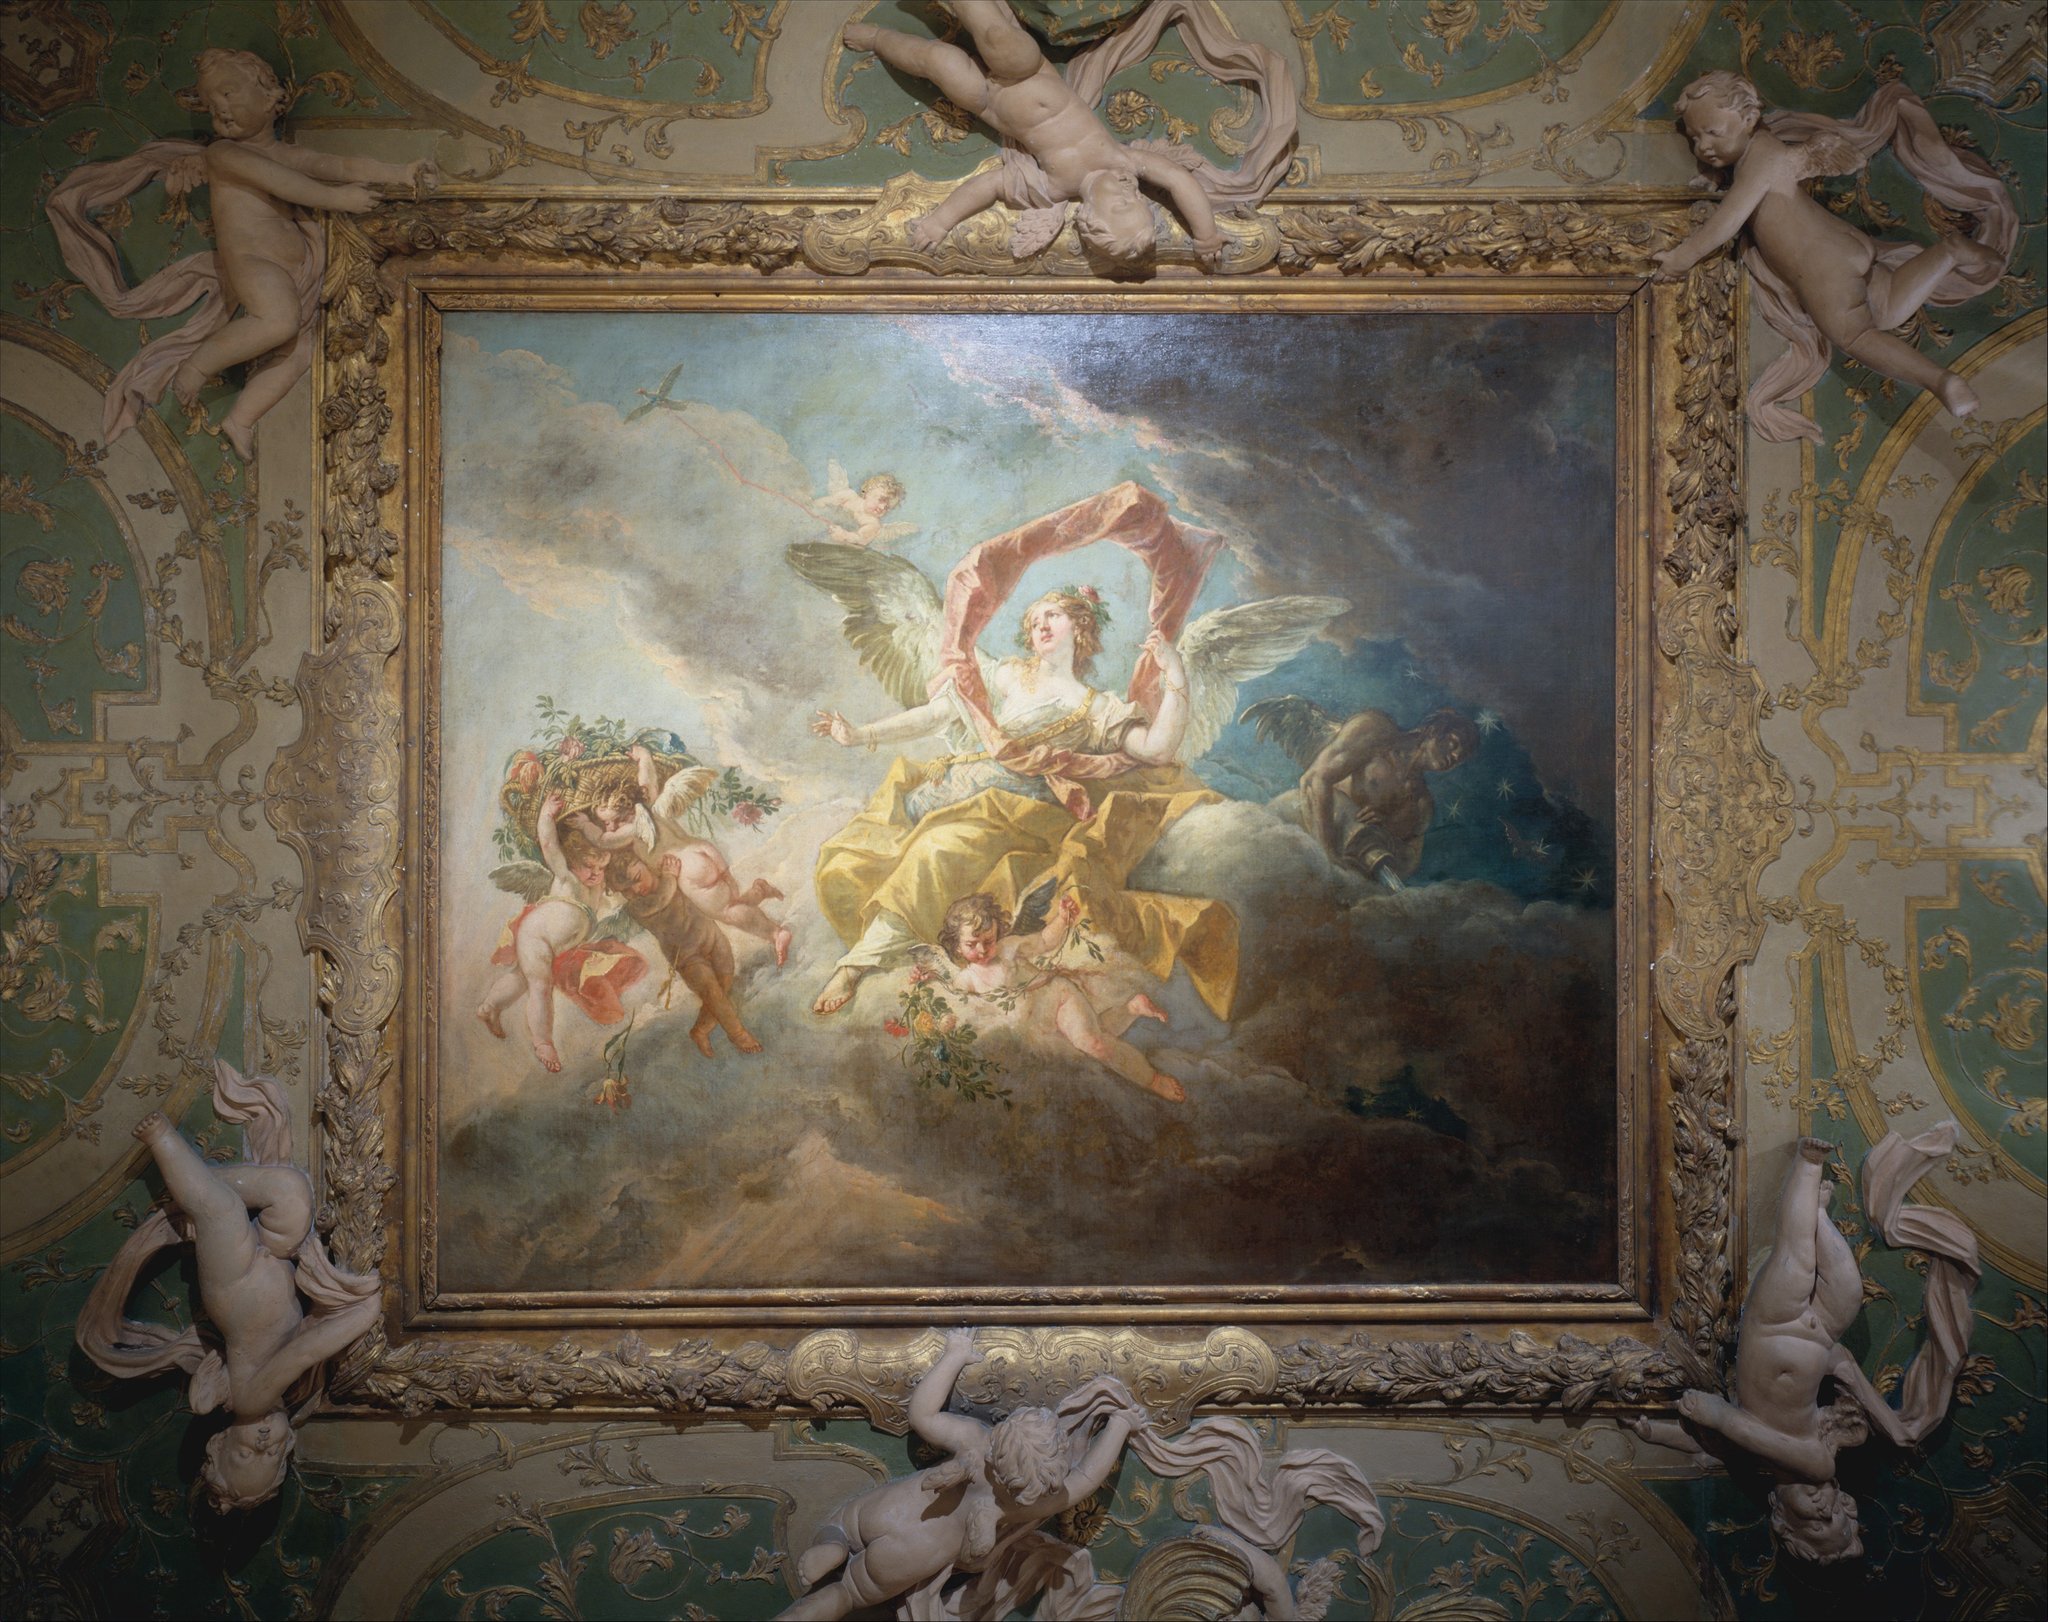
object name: painting, ceiling decoration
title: Dawn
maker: gaspare diziani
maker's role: artist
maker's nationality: italian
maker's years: 1689-1767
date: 1709-1767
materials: canvas, oil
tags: putti,dawn